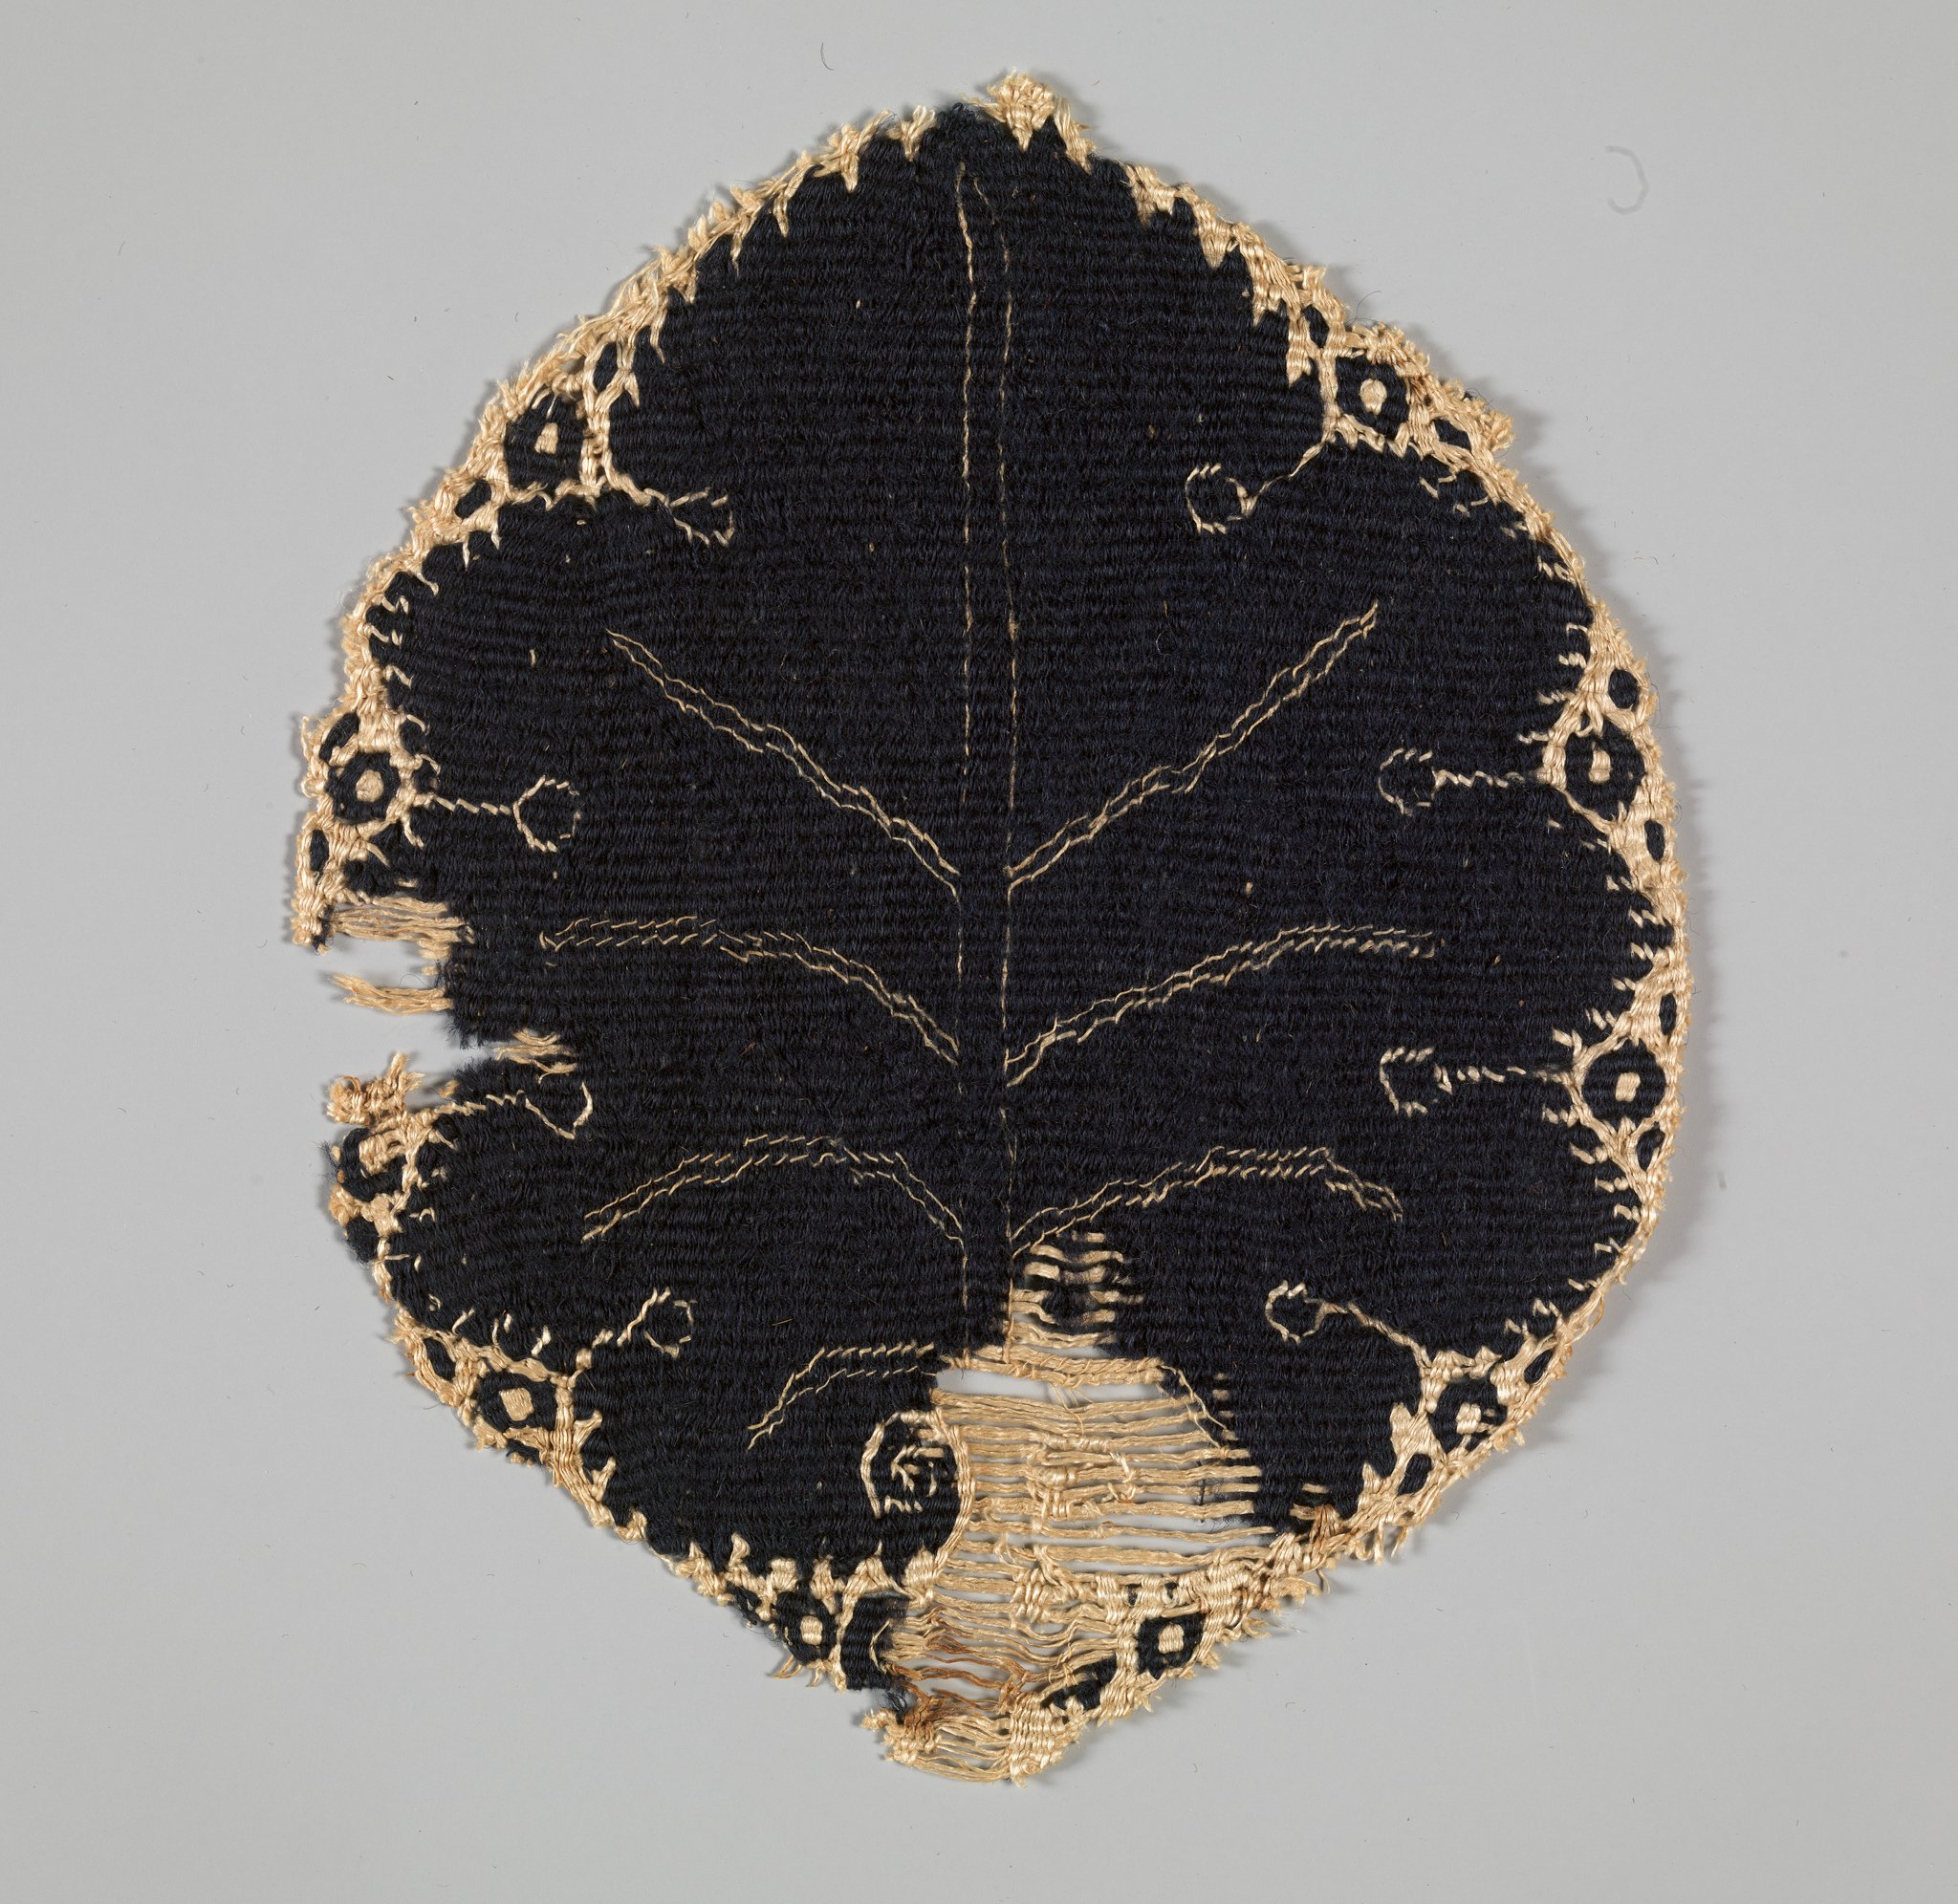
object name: textile fragment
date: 201-400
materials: linen, wool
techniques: weave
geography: egypt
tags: leaves